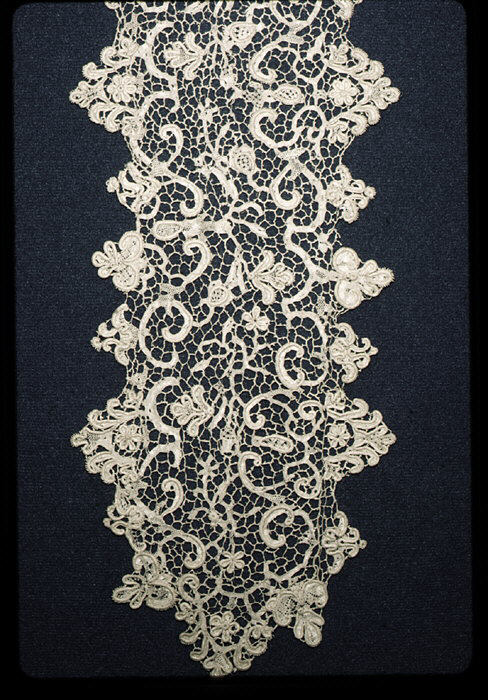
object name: lappet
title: Lappet (one of a pair)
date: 1701-1733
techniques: lace